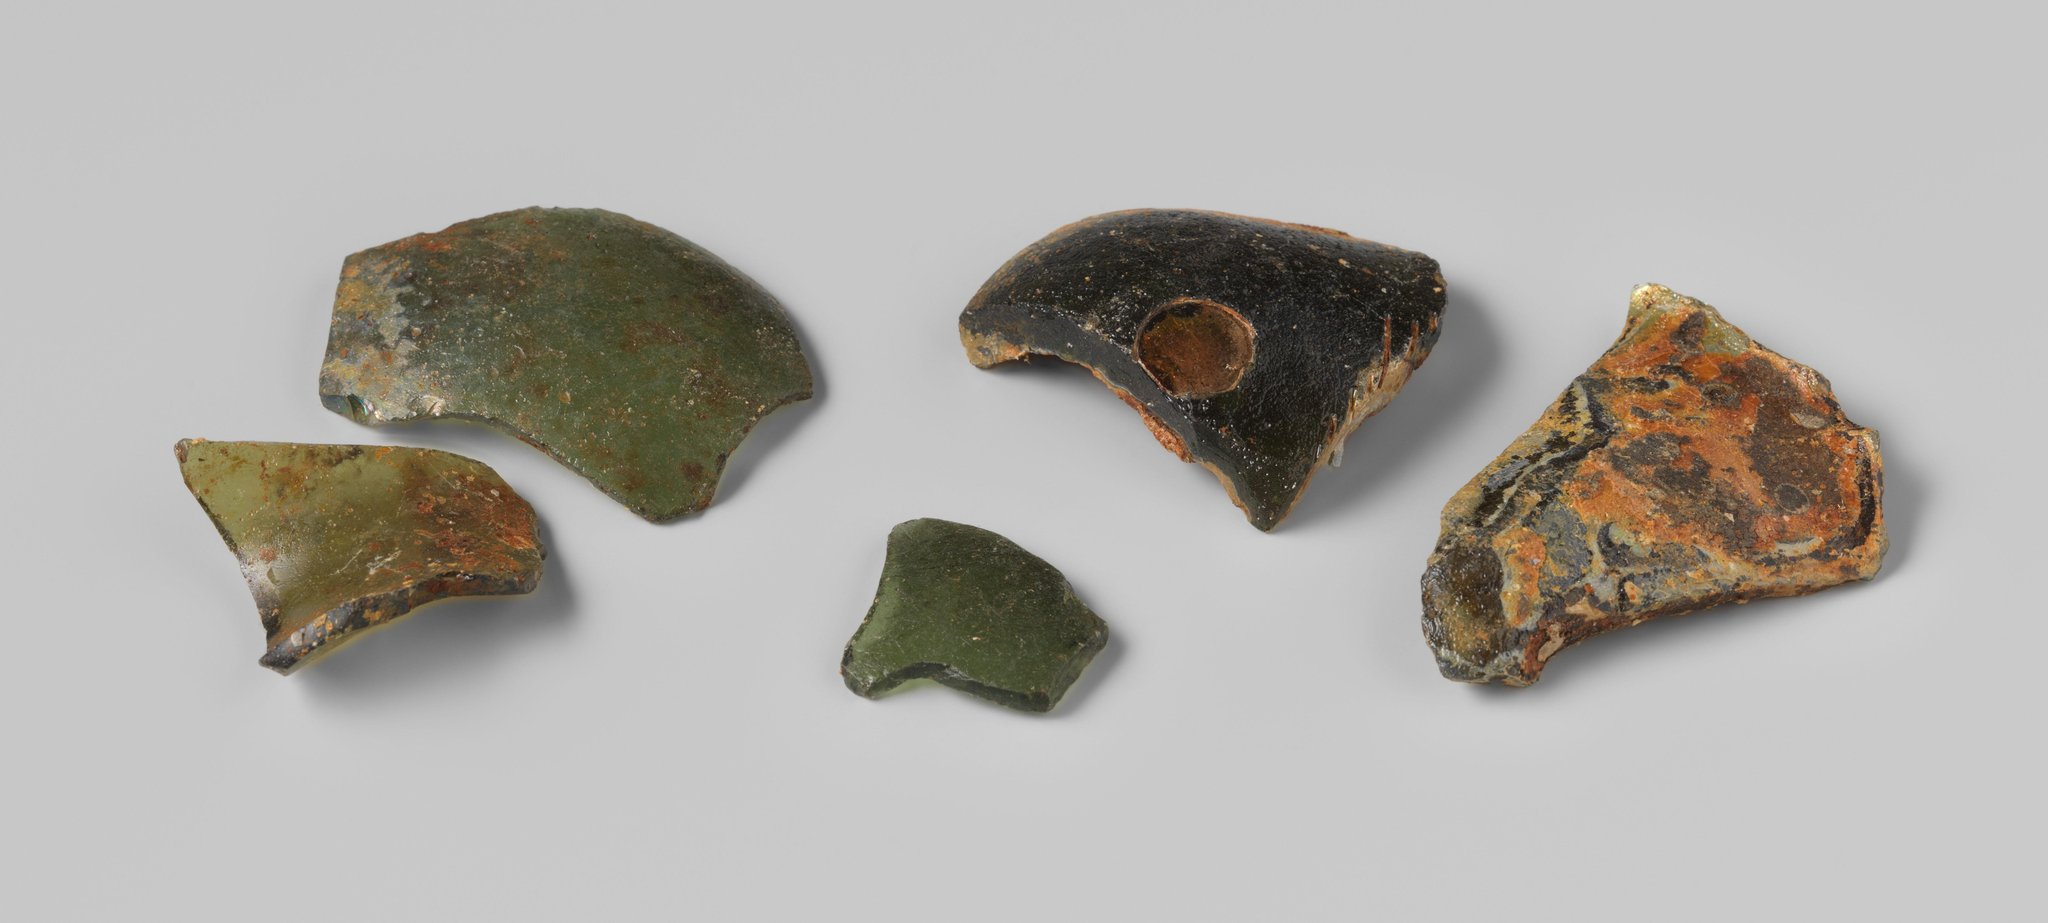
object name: sherd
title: Scherven van wijnflessen uit het wrak van de Oostindiëvaarder Hollandia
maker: Anonymous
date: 1700-1743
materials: glass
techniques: green glass